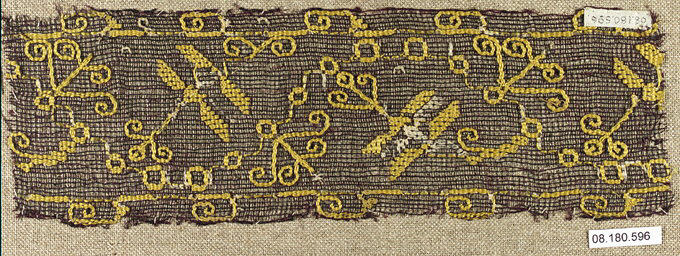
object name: band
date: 1501-1600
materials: silk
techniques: embroidery